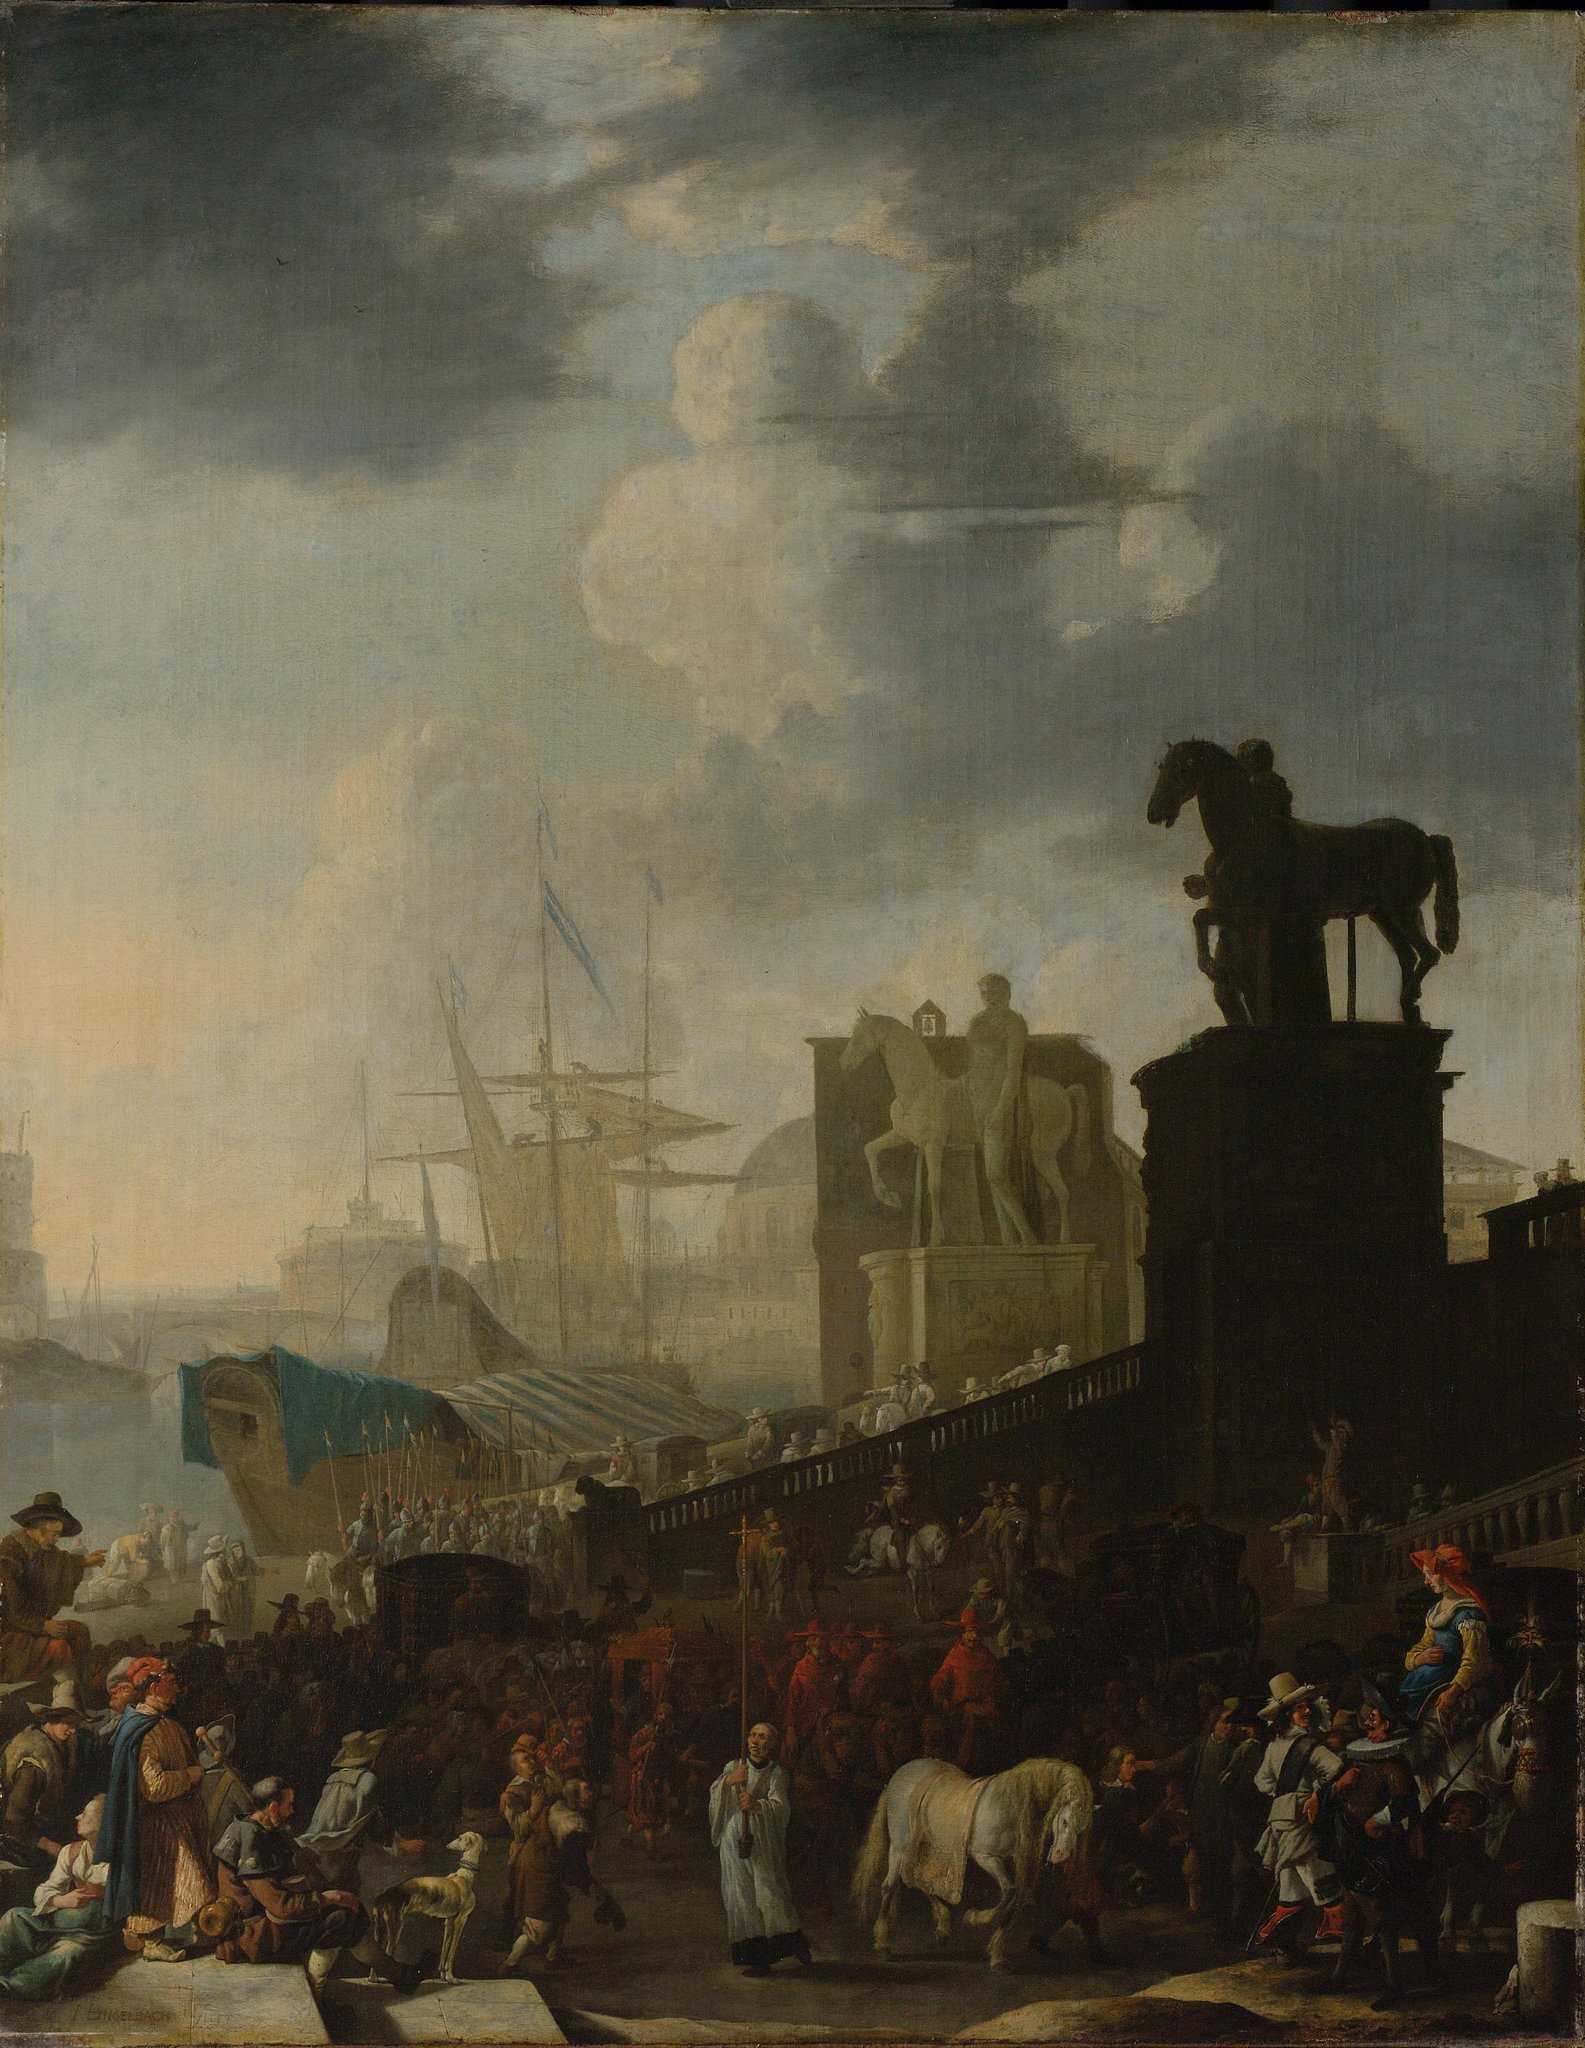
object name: painting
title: The Climbing of the Capitol with the Grey Horse of the Newly Elected Pope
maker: johannes lingelbach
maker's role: draughtsman, painter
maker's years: 1622-1674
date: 1650-1674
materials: canvas, oil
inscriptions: signature: ‘J. Lingelbach fecet’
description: De opgang naar het Kapitool met het witte paard van de nieuw gekozen paus, begeleid door een priester met een kruis. Op de voorgrond de toegestroomde menigte, links schapen aan de kade van de rivier. Rechts de trappen van het Kapitool met de grote standbeelden op voetstukken van paarden. In de verte andere gebouwen van Rome: de Engelenburcht en de koepel van de Sint Pieter.